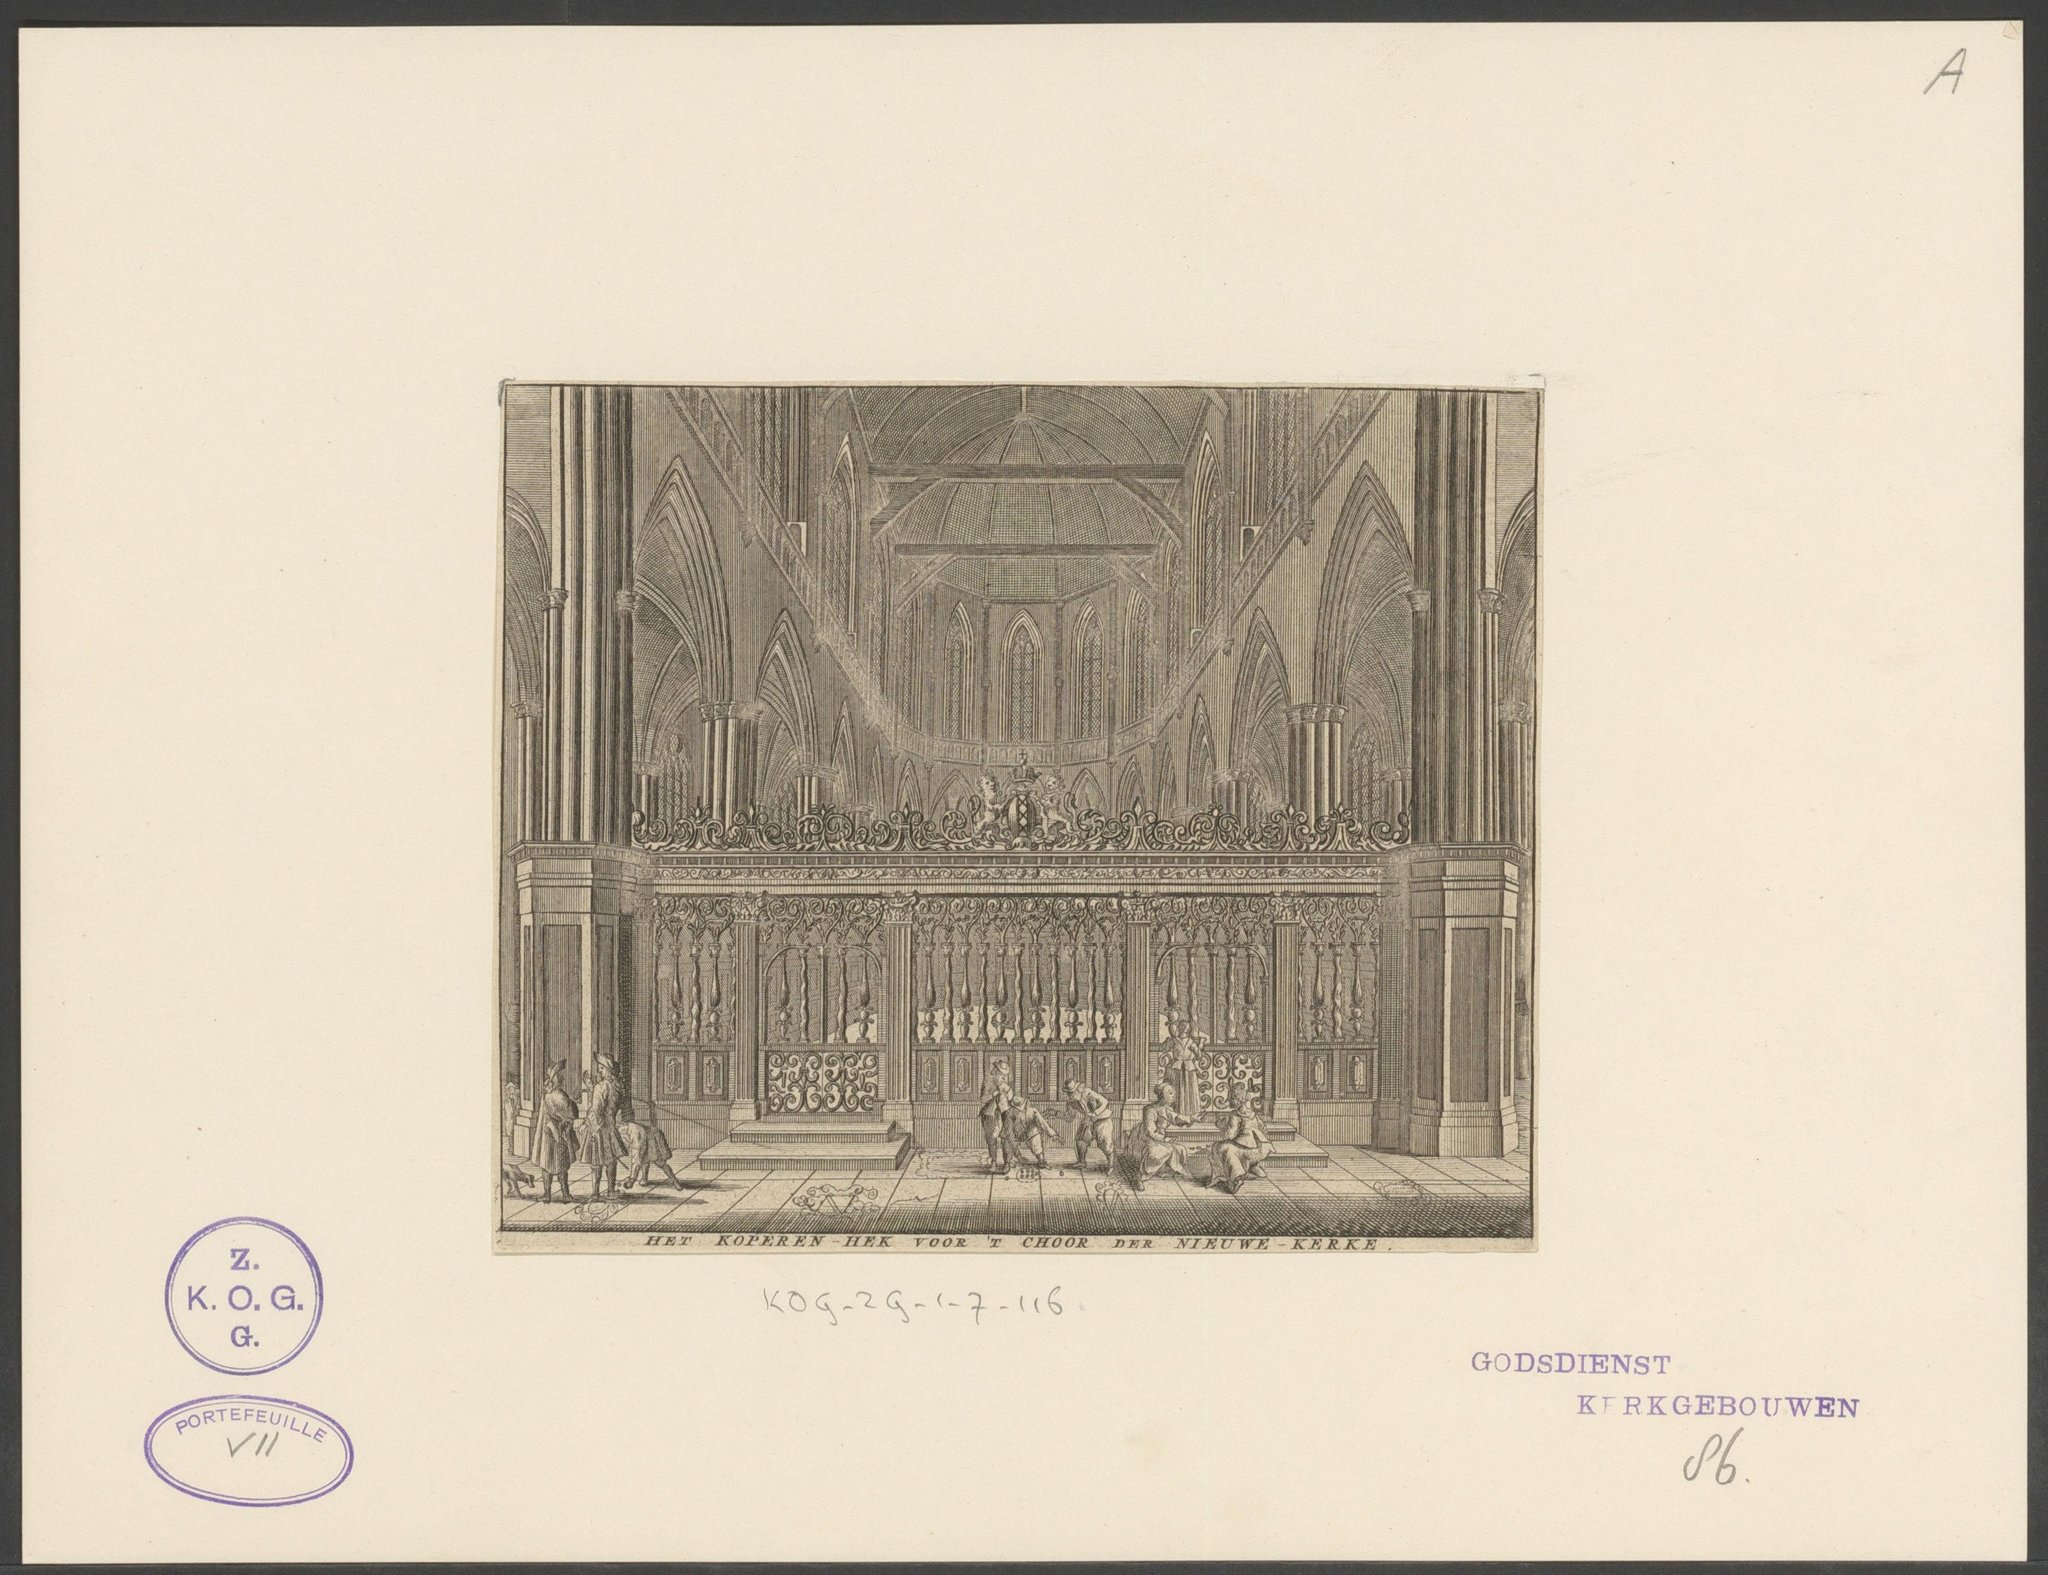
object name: print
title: Het koperen-hek voor 't choor der Nieuwe-Kerke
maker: Anonymous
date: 1763-1765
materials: paper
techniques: etching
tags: interior of church, parts of church interior: choir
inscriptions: stamp, stamp, collector's mark: Lugt 1641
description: Prent mogelijk uit: Wagenaar, Jan. Amsterdam, in zyne opkomst, aanwas, geschiedenissen, voorregten, koophandel, gebouwen, kerkenstaat, schoolen, schutterye, gilden en regeringe, beschreeven. 3 dln. Amsterdam: Isaak Tirion, 1760-1767, dl. 2 (1765).